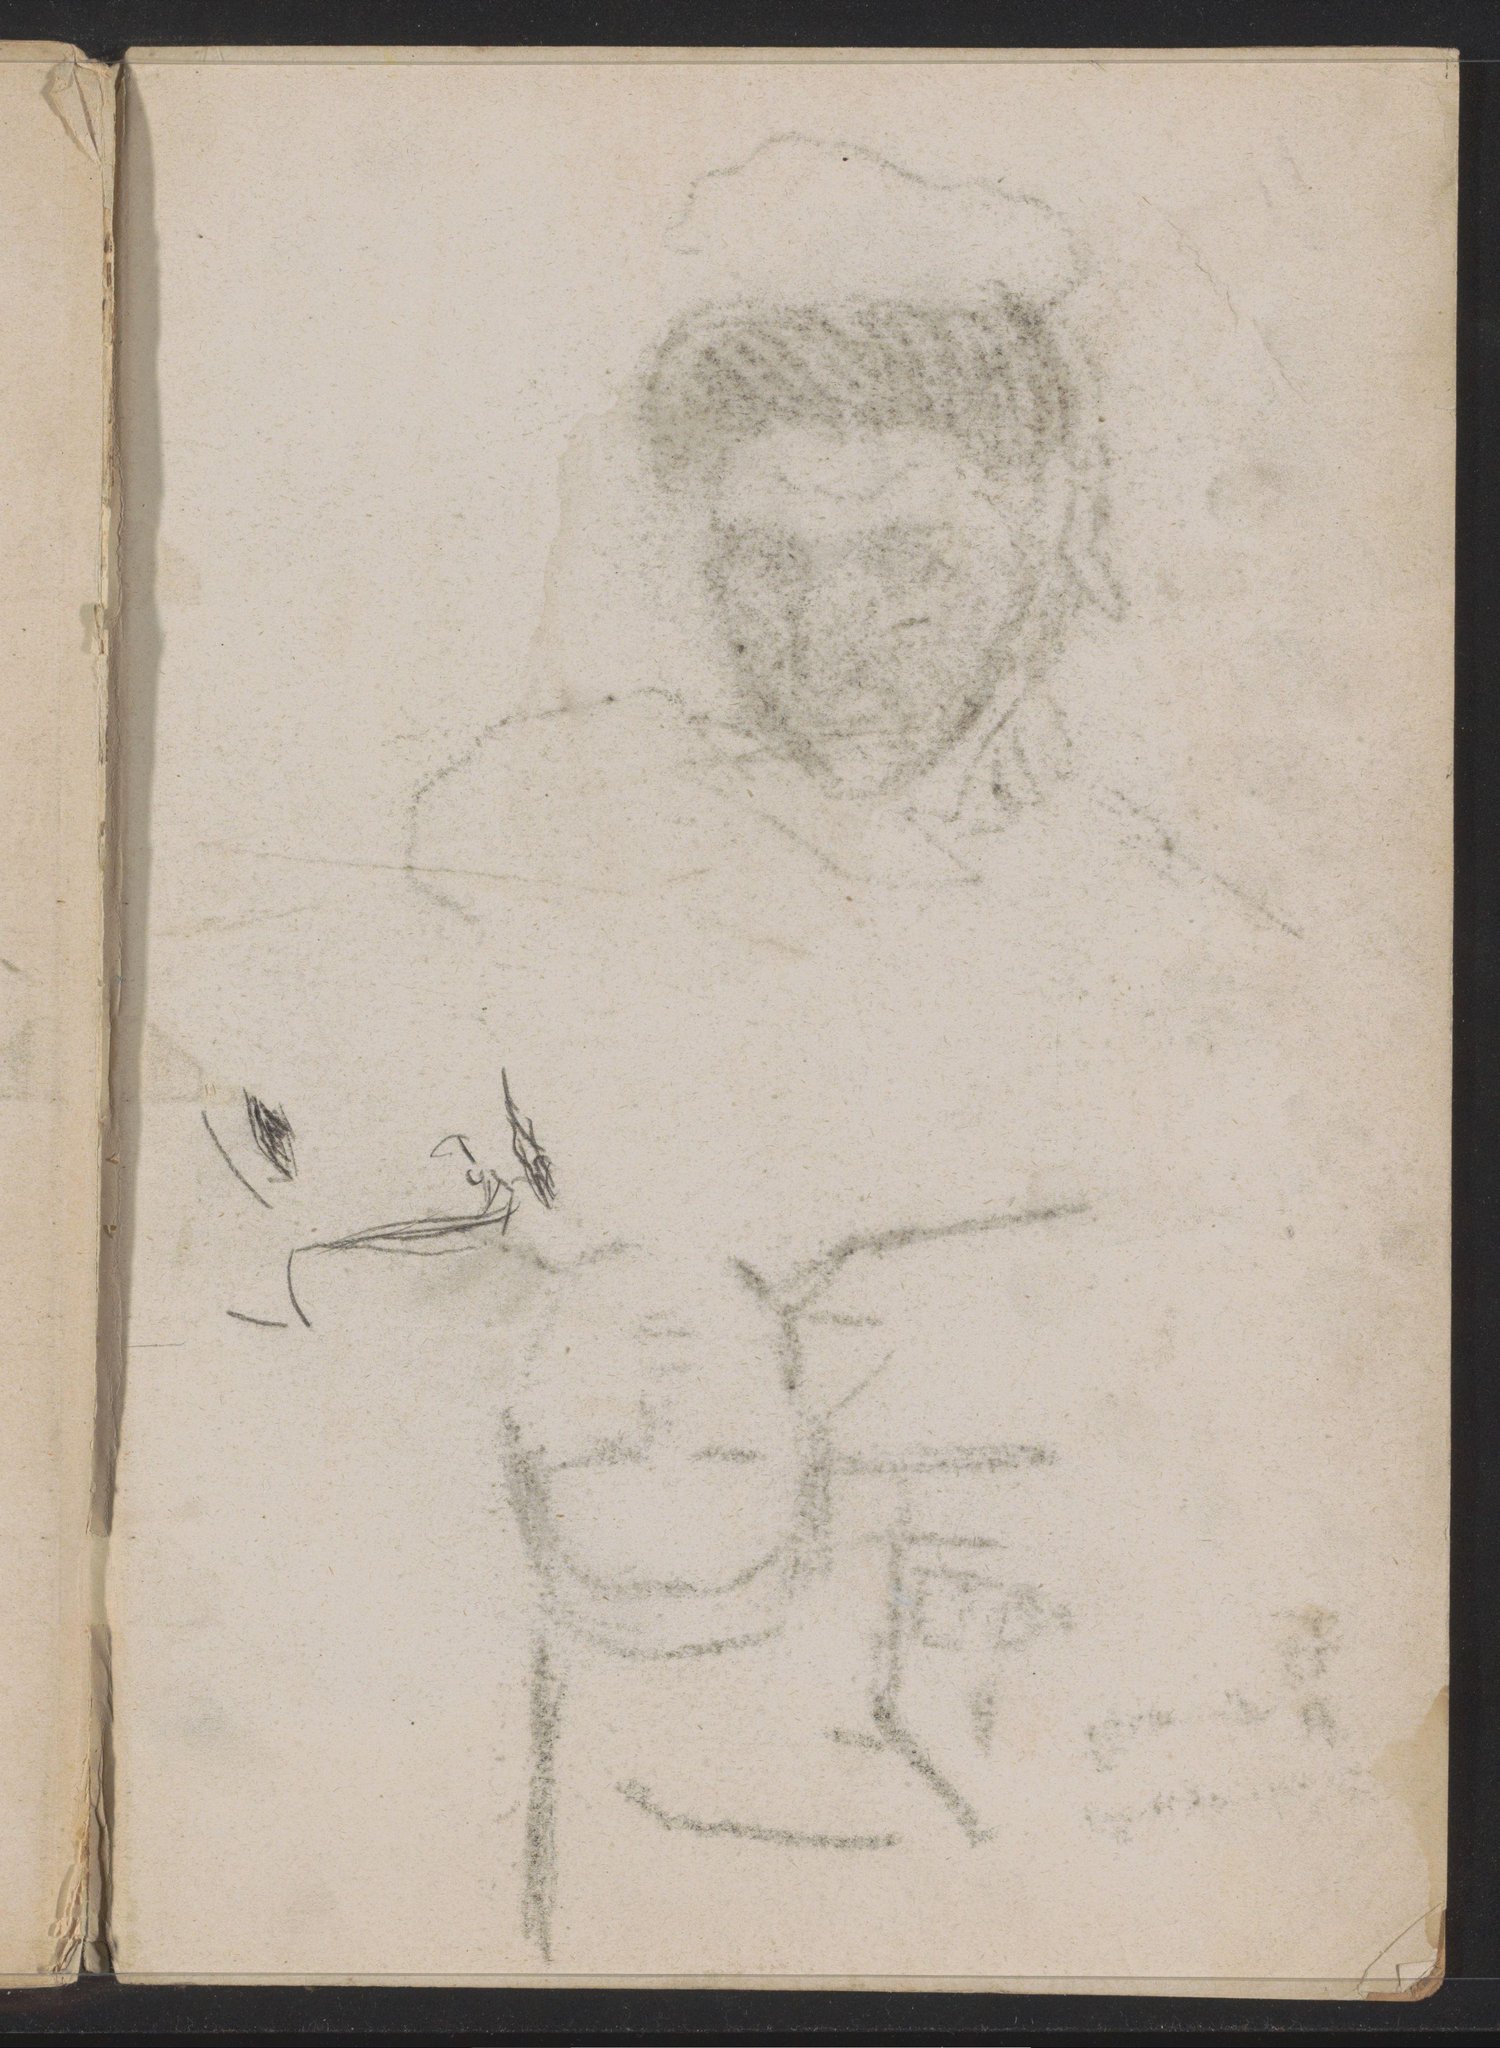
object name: sketchbook leaf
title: Gezicht van een vrouw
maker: isaac israels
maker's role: draughtsman, painter, print maker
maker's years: 1865-1934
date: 1886-1934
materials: chalk, paper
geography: amsterdam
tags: face, adult woman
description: Schutblad B, achterste schutblad, uit schetsboek LXVI-B met 25 bladen.